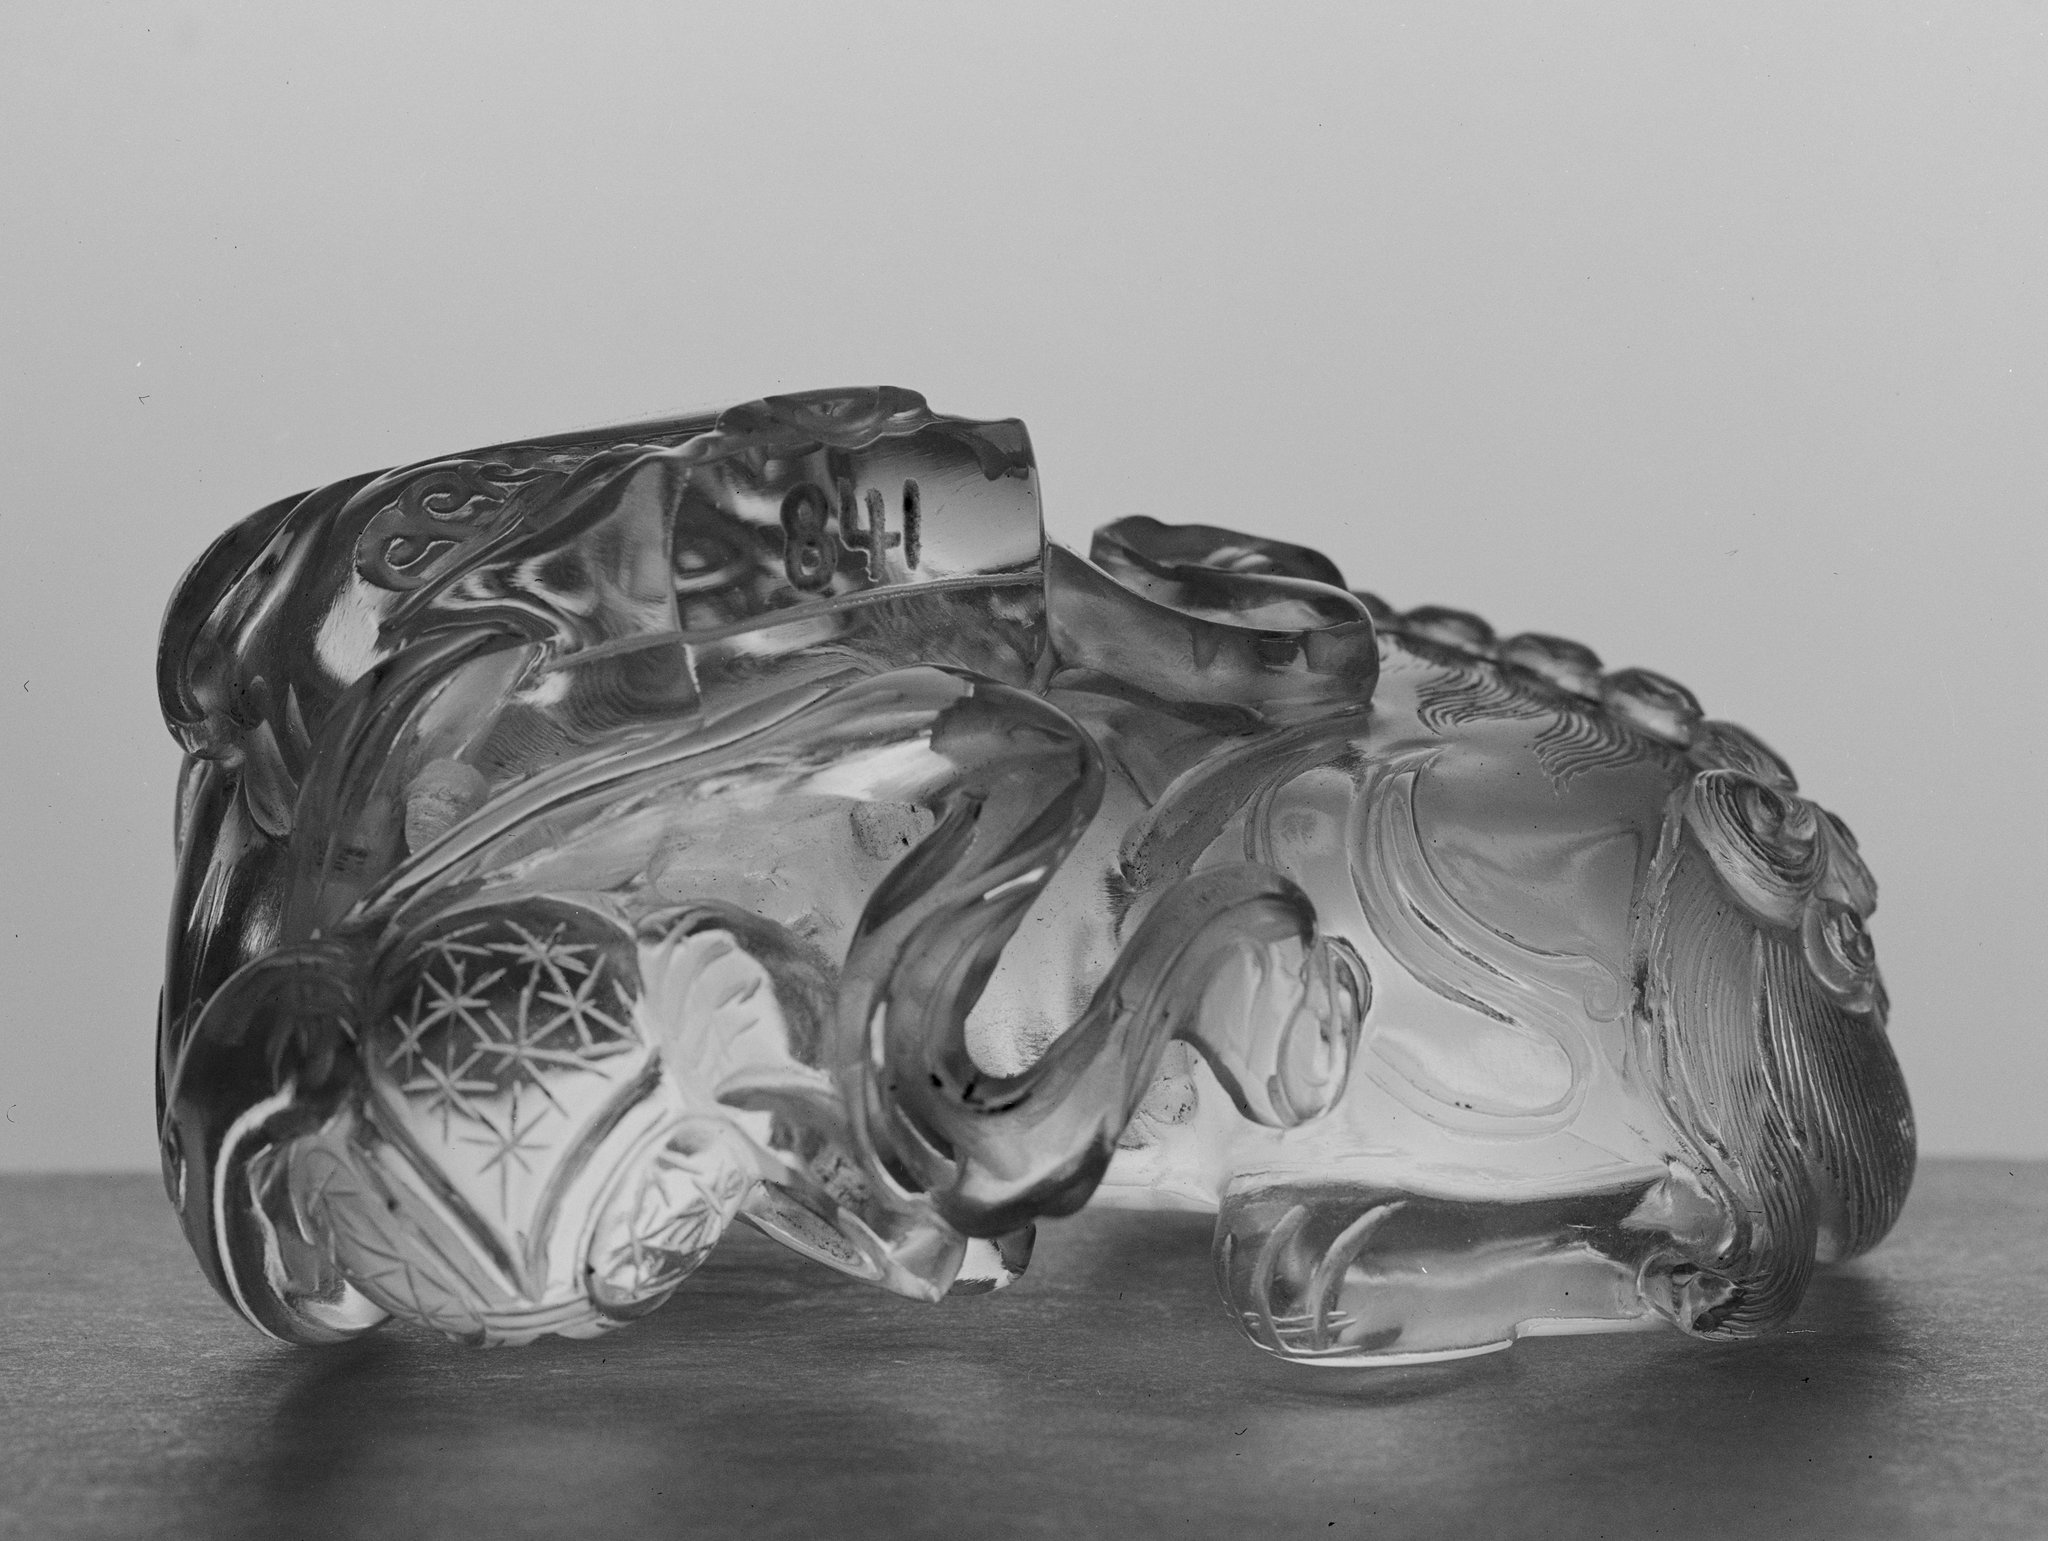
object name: paperweight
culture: chinese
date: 1701-1800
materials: quartz